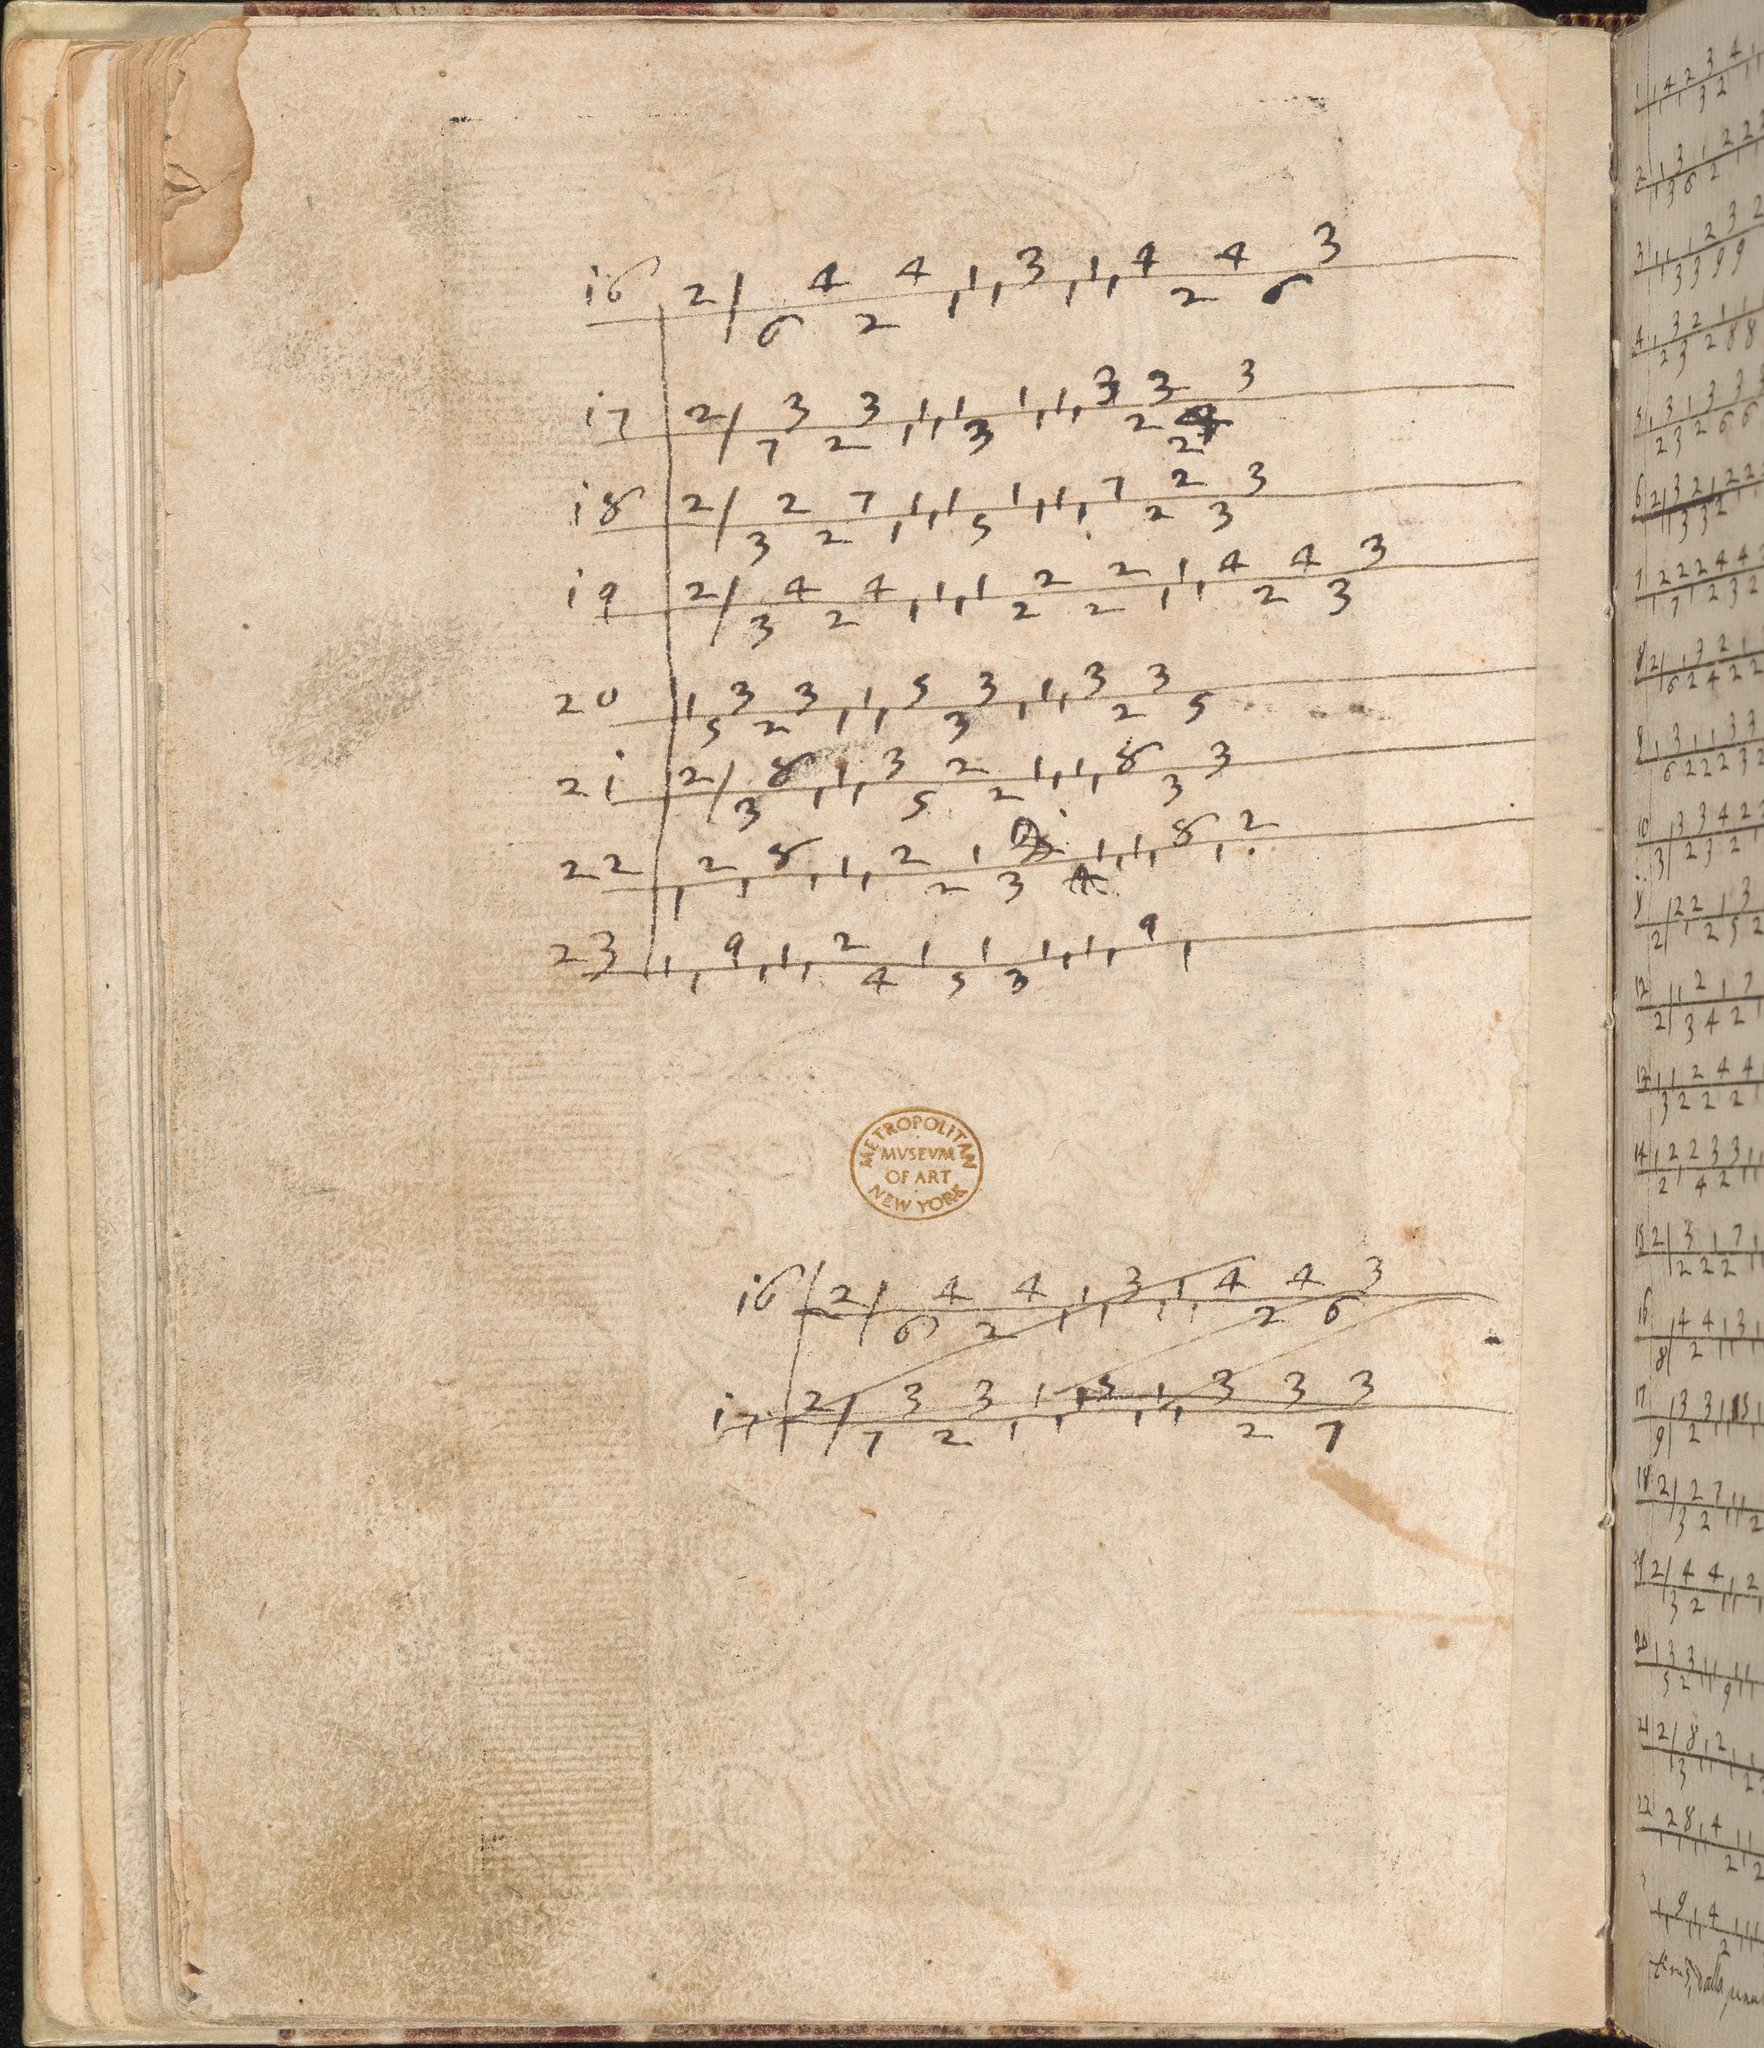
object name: book print ornament architecture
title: Ein new getruckt model Büchli...Page 24, verso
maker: johann schönsperger the younger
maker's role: publisher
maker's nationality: german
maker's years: 1490-1550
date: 1529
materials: ink, paper